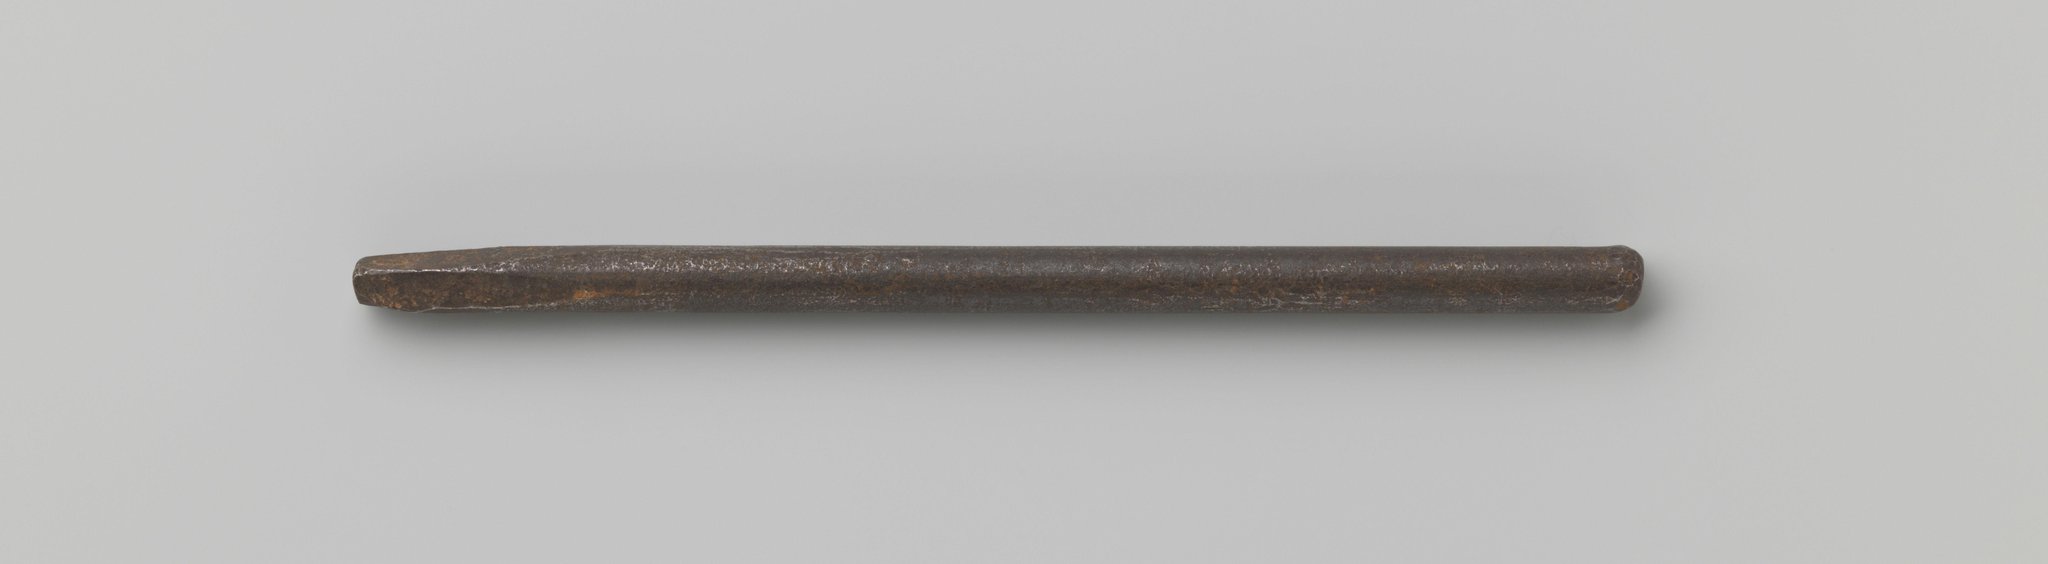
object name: key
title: Sleutel van een geldkist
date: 1700-1800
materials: iron